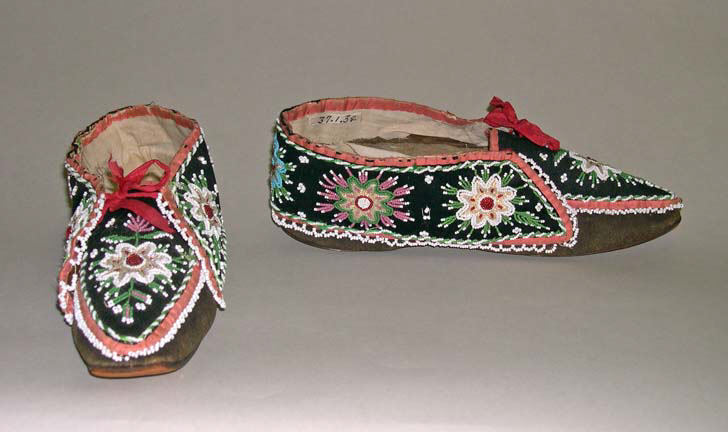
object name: shoe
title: Shoes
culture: huron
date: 1830-1840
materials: silk, wool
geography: united states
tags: shoes,flowers